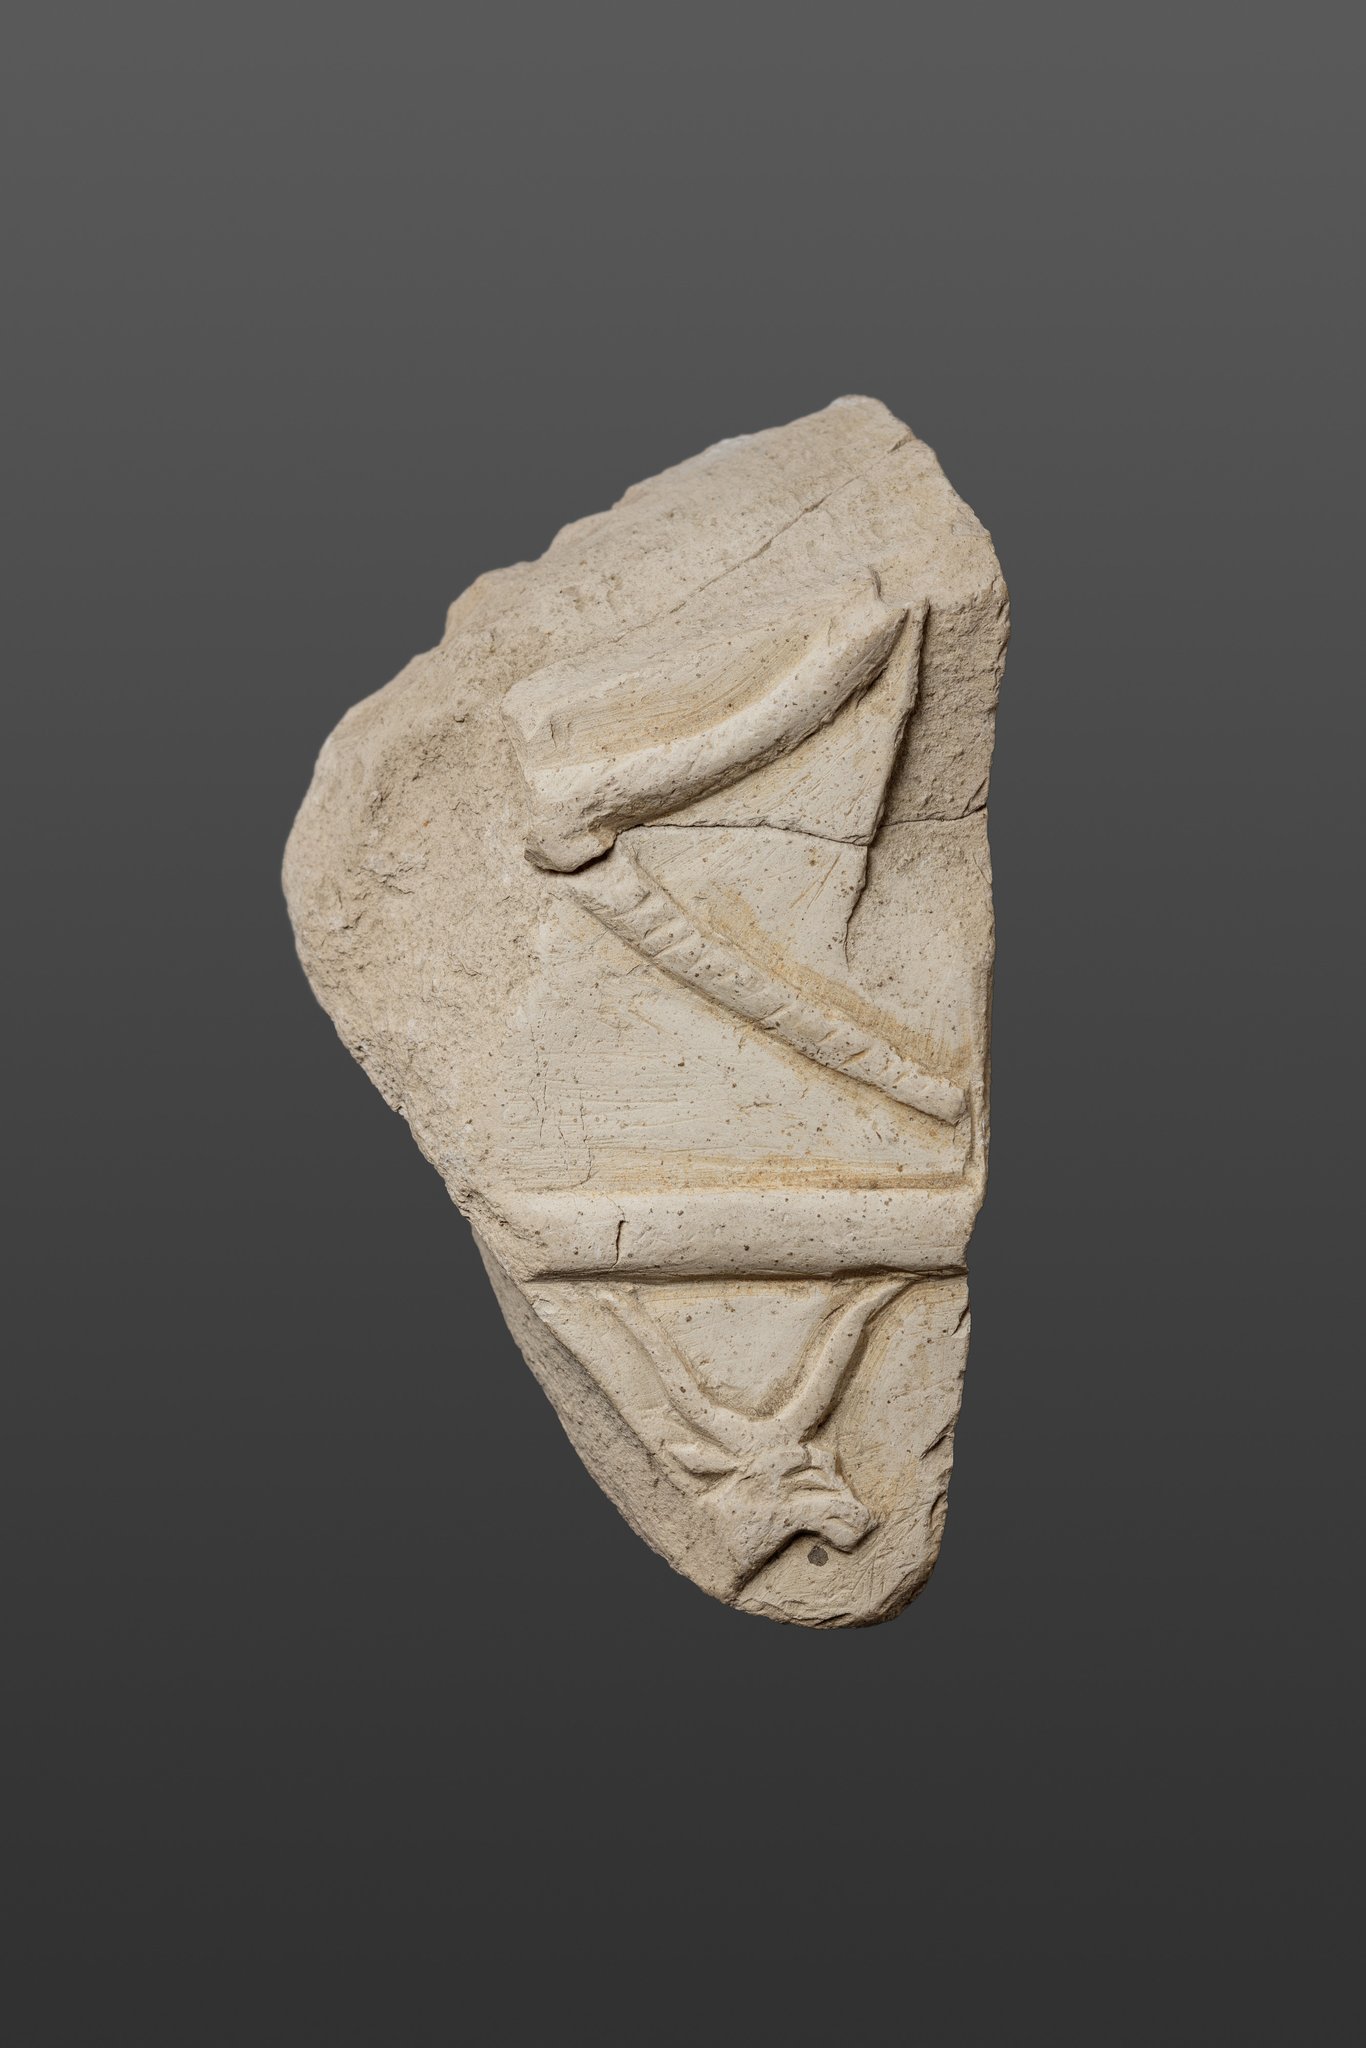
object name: relief fragment 41, tomb of mereri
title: Relief fragment possibly from the tomb of Mereri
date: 2100-2090 BCE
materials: limestone